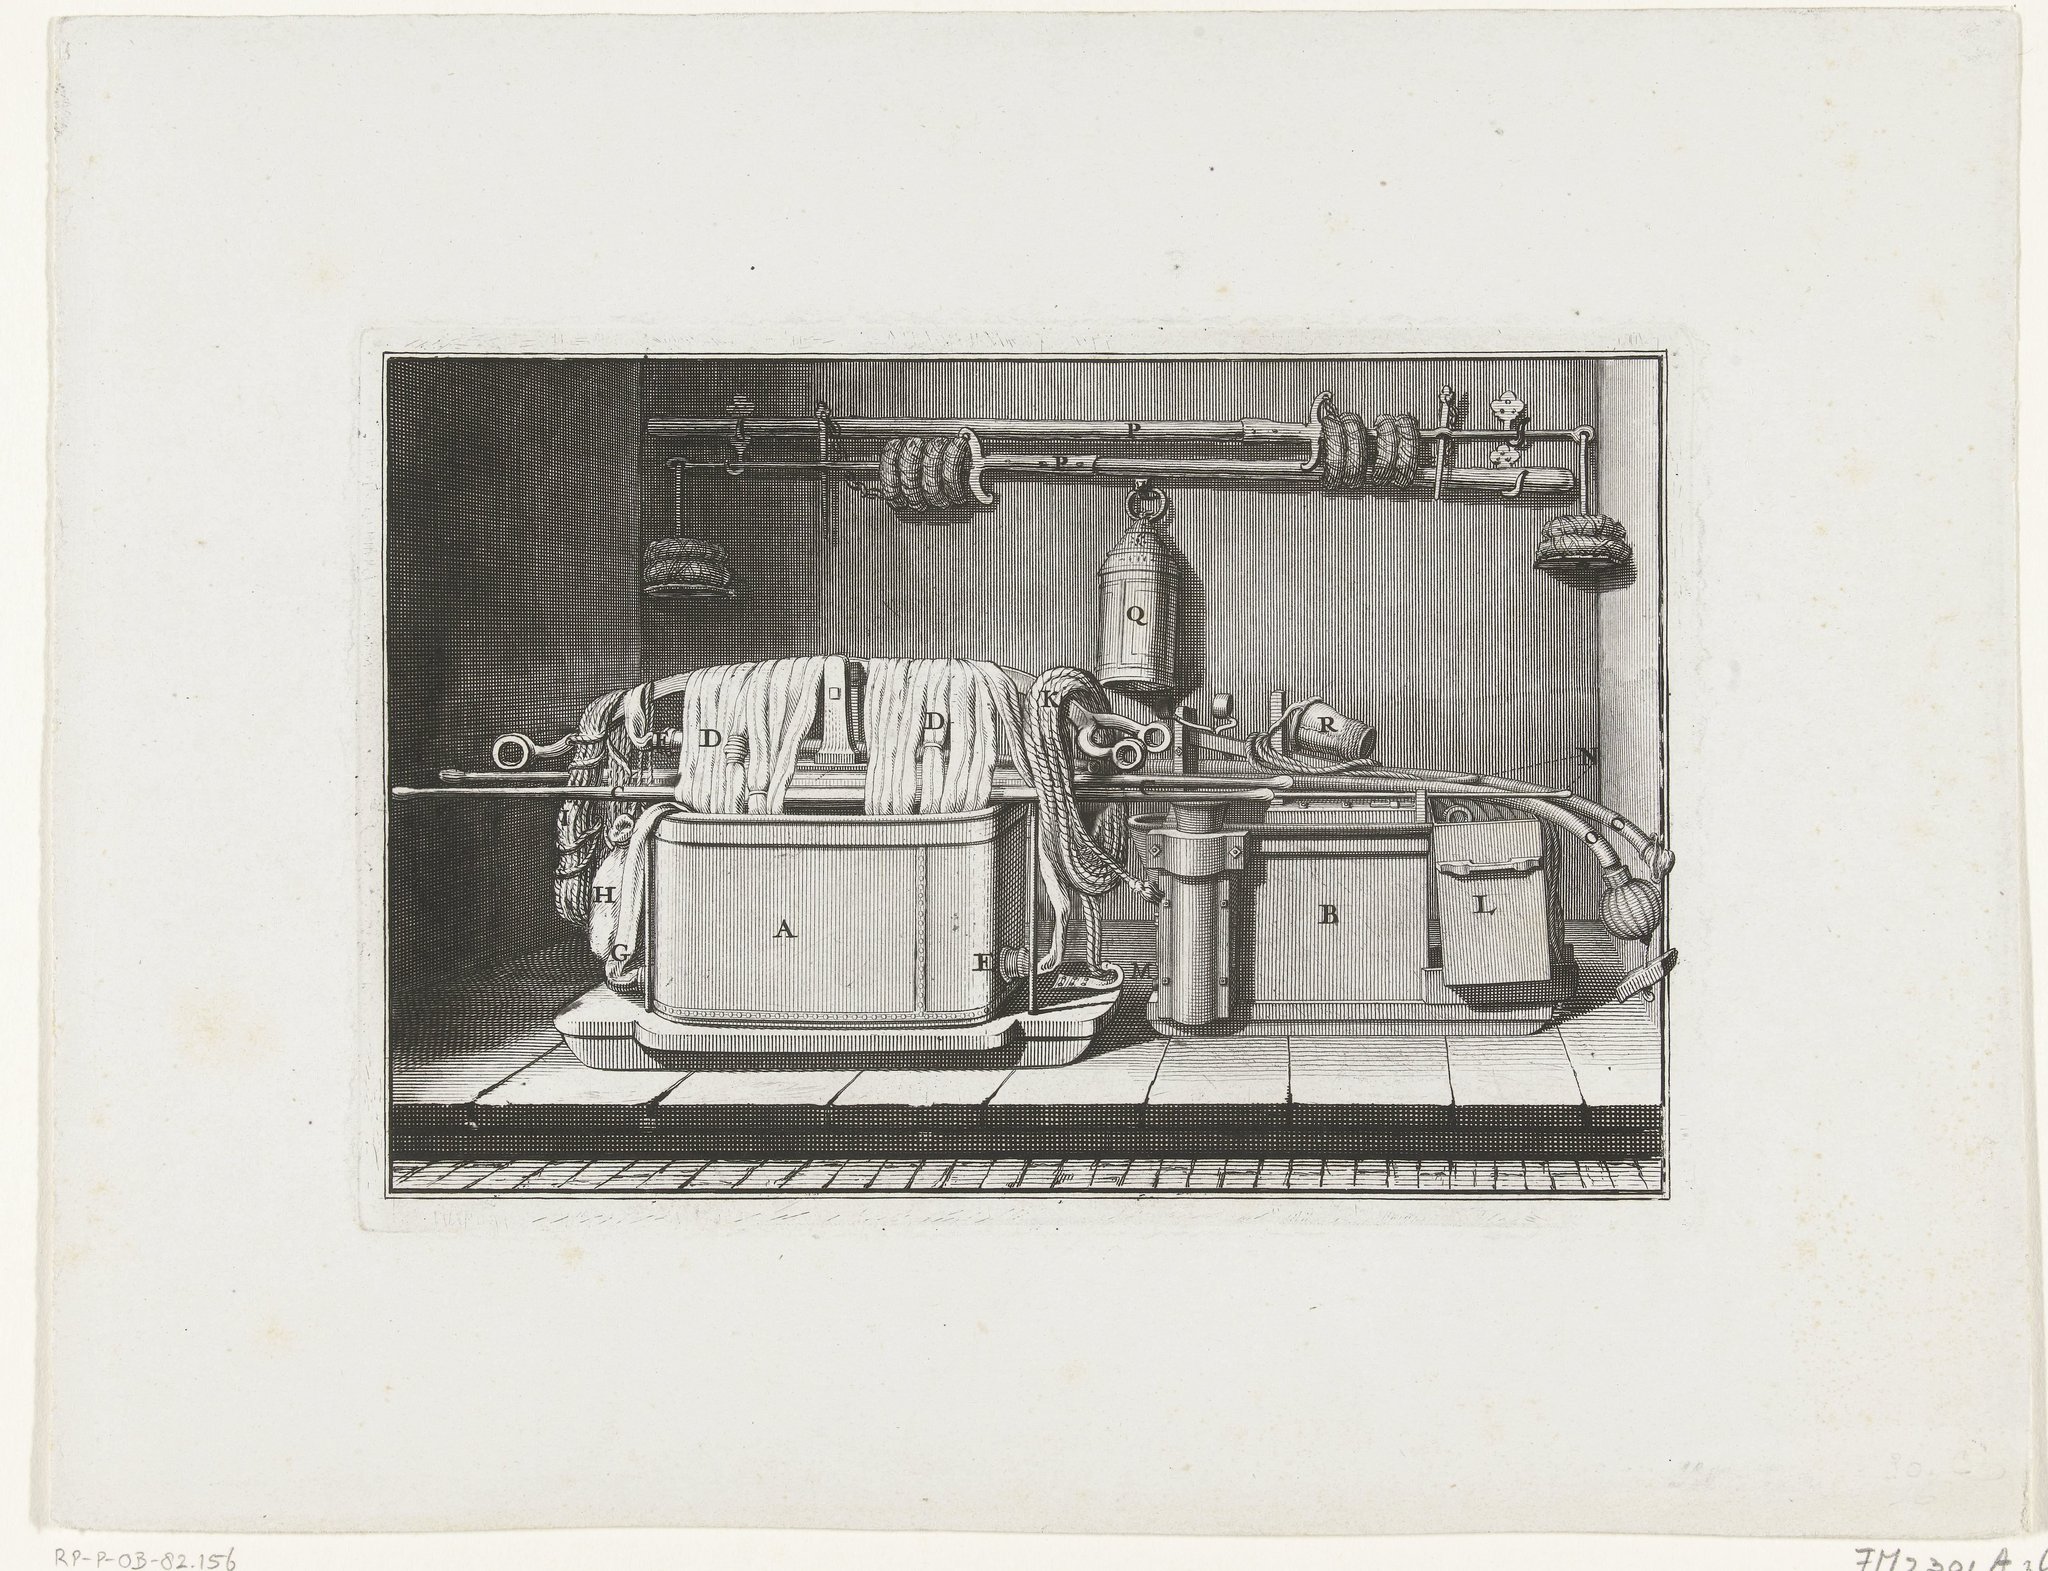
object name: print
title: Slangbrandspuit en pomp opgeborgen in een brandspuithuis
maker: Anonymous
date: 1690-1699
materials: paper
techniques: engraving, etching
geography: northern netherlands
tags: amsterdam, painter, print maker, draughtsman, jan van der heyden, fire-extinguishing equipment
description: Hoe de slangbrandspuit en pomp in het brandspuithuisje opgeborgen dient te worden na gebruik. Gebruikt in de instructie over het correcte gebruik en bewaring van de slangbrandspuiten, ca. 1695. Behoort tot de bijprenten bij het Brandspuitenboek van Jan van der Heyden.